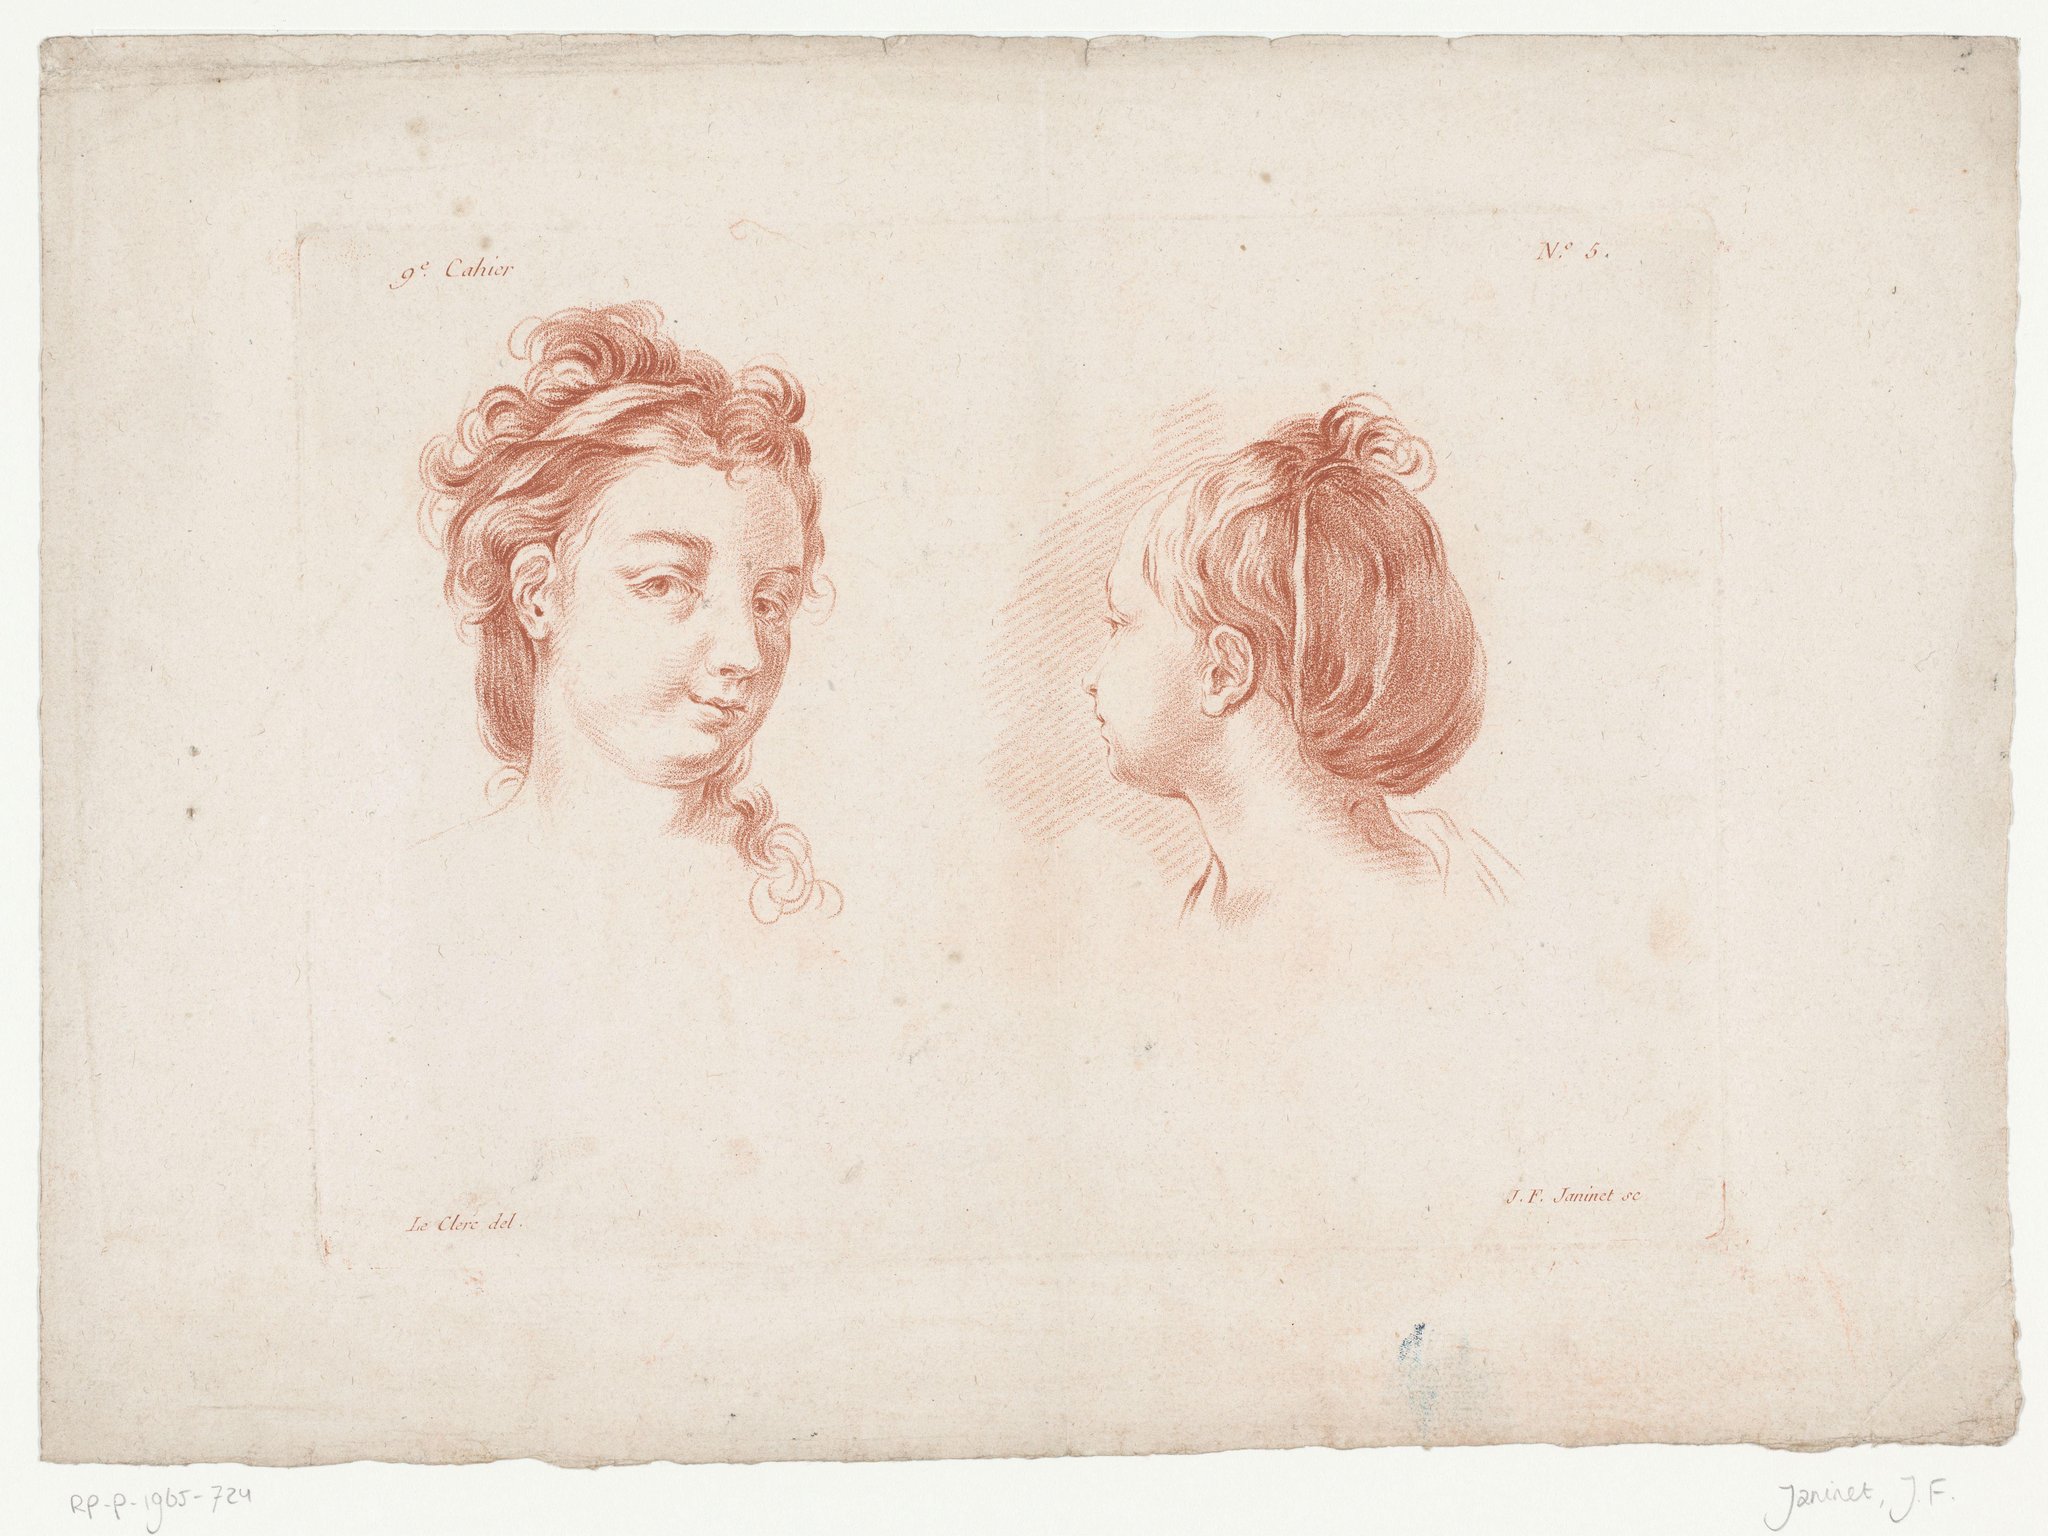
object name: print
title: IXe Cahier de Principes du Dessin d'après nature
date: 1773-1777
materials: paper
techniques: printmaking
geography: france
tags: head (human) - aa - female human figure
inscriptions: collector's mark: Lugt 2228, watermark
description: Deze prent maakt deel uit van een album dat uit minstens elf delen bestaat. Dit is het vijfde blad uit het negende album. Waarschijnlijk dienden deze albums als voorbeeld voor tekenaars, schilders en graveurs.